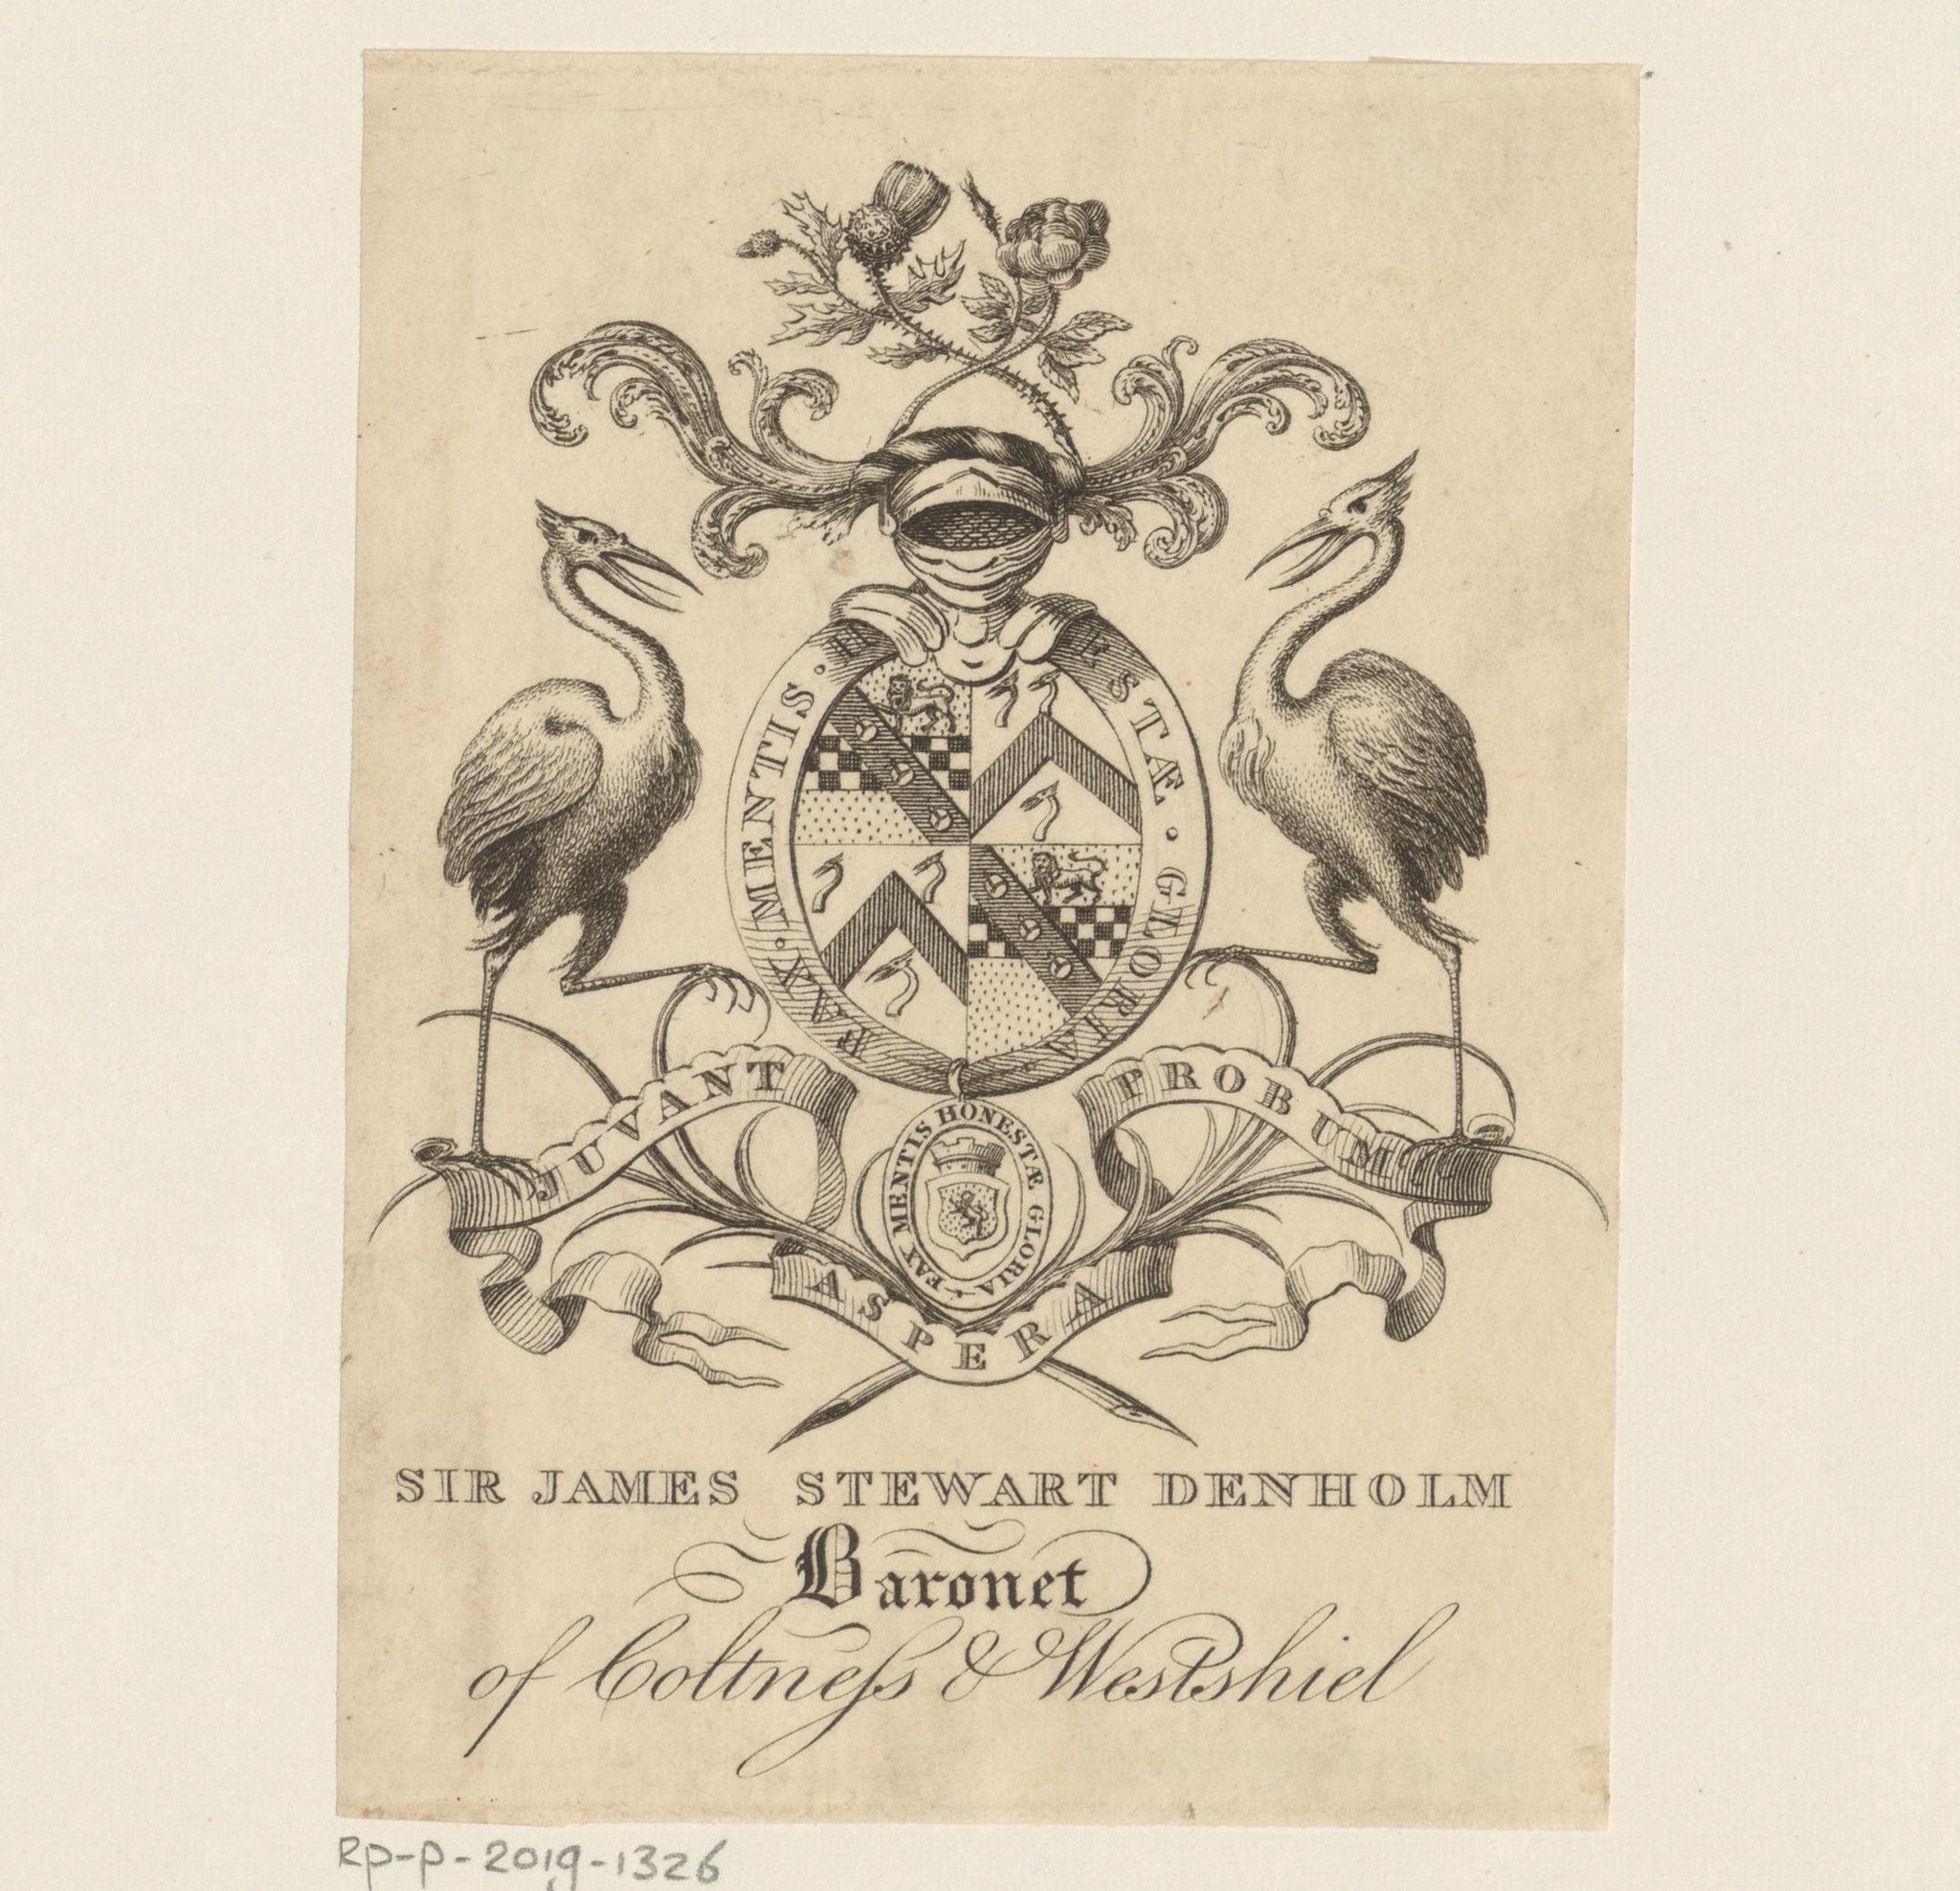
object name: bookplate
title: Juvant aspera probum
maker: Anonymous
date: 1754-1839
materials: paper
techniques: engraving, etching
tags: politician, armorial bearing, heraldry